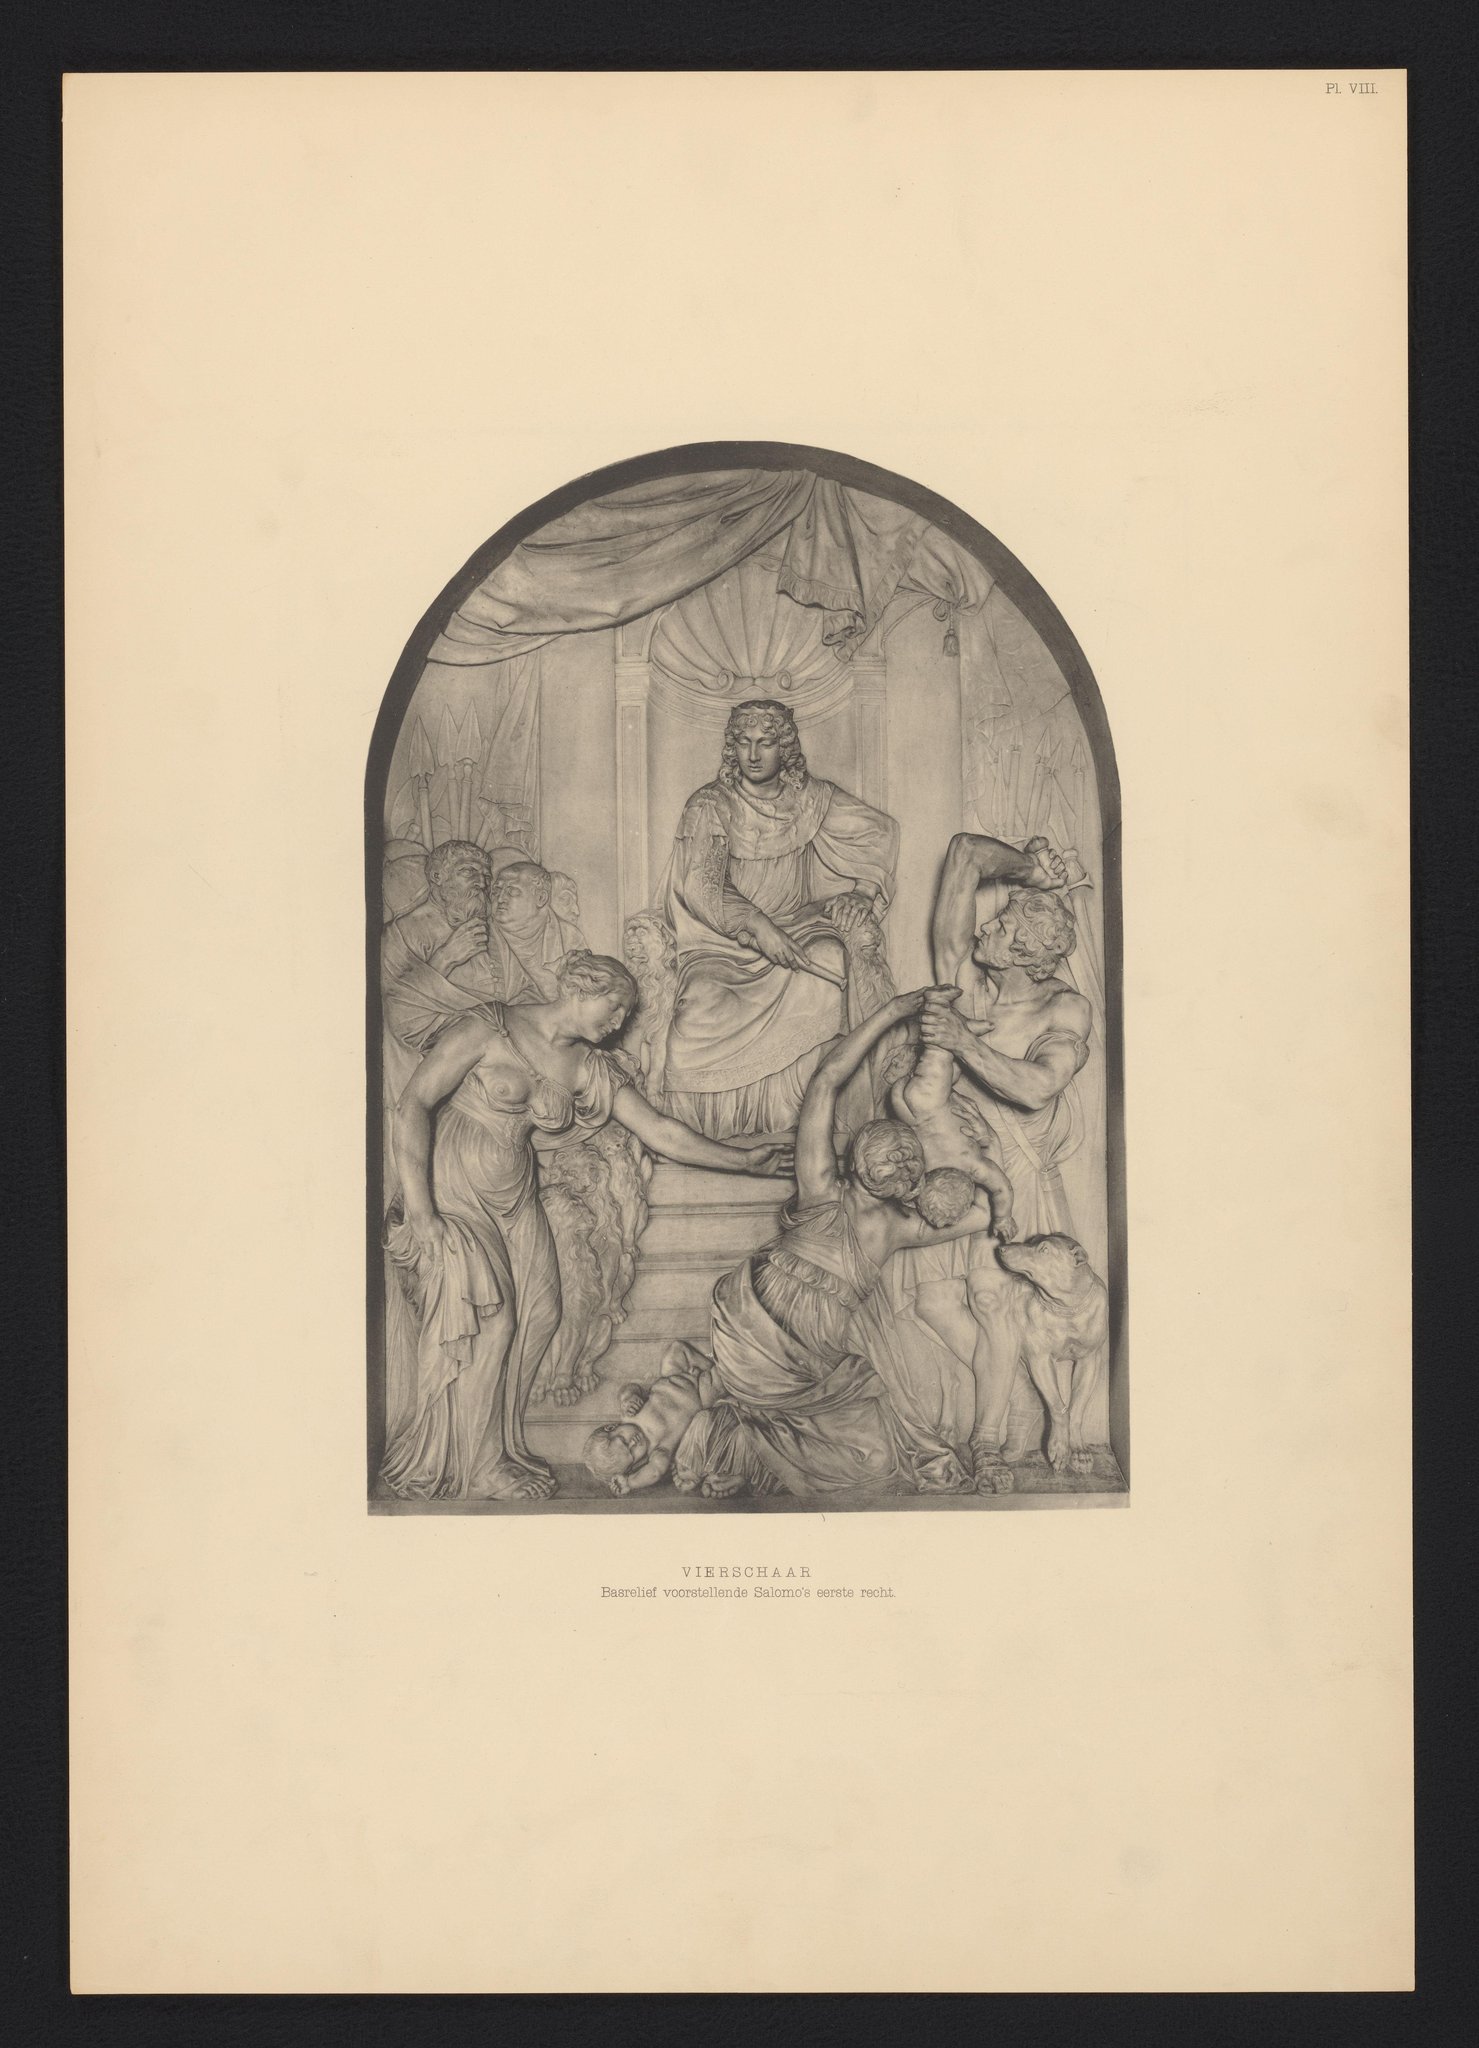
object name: fotomechanisch procedé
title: Het Koninklijk Paleis te Amsterdam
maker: Anonymous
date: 1899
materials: cardboard, paper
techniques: photograph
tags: palace, piece of sculpture, reproduction of a piece of sculpture, royal palace of amsterdam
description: Vierschaar. / Basreliëf voorstellende Simon's eerste recht.